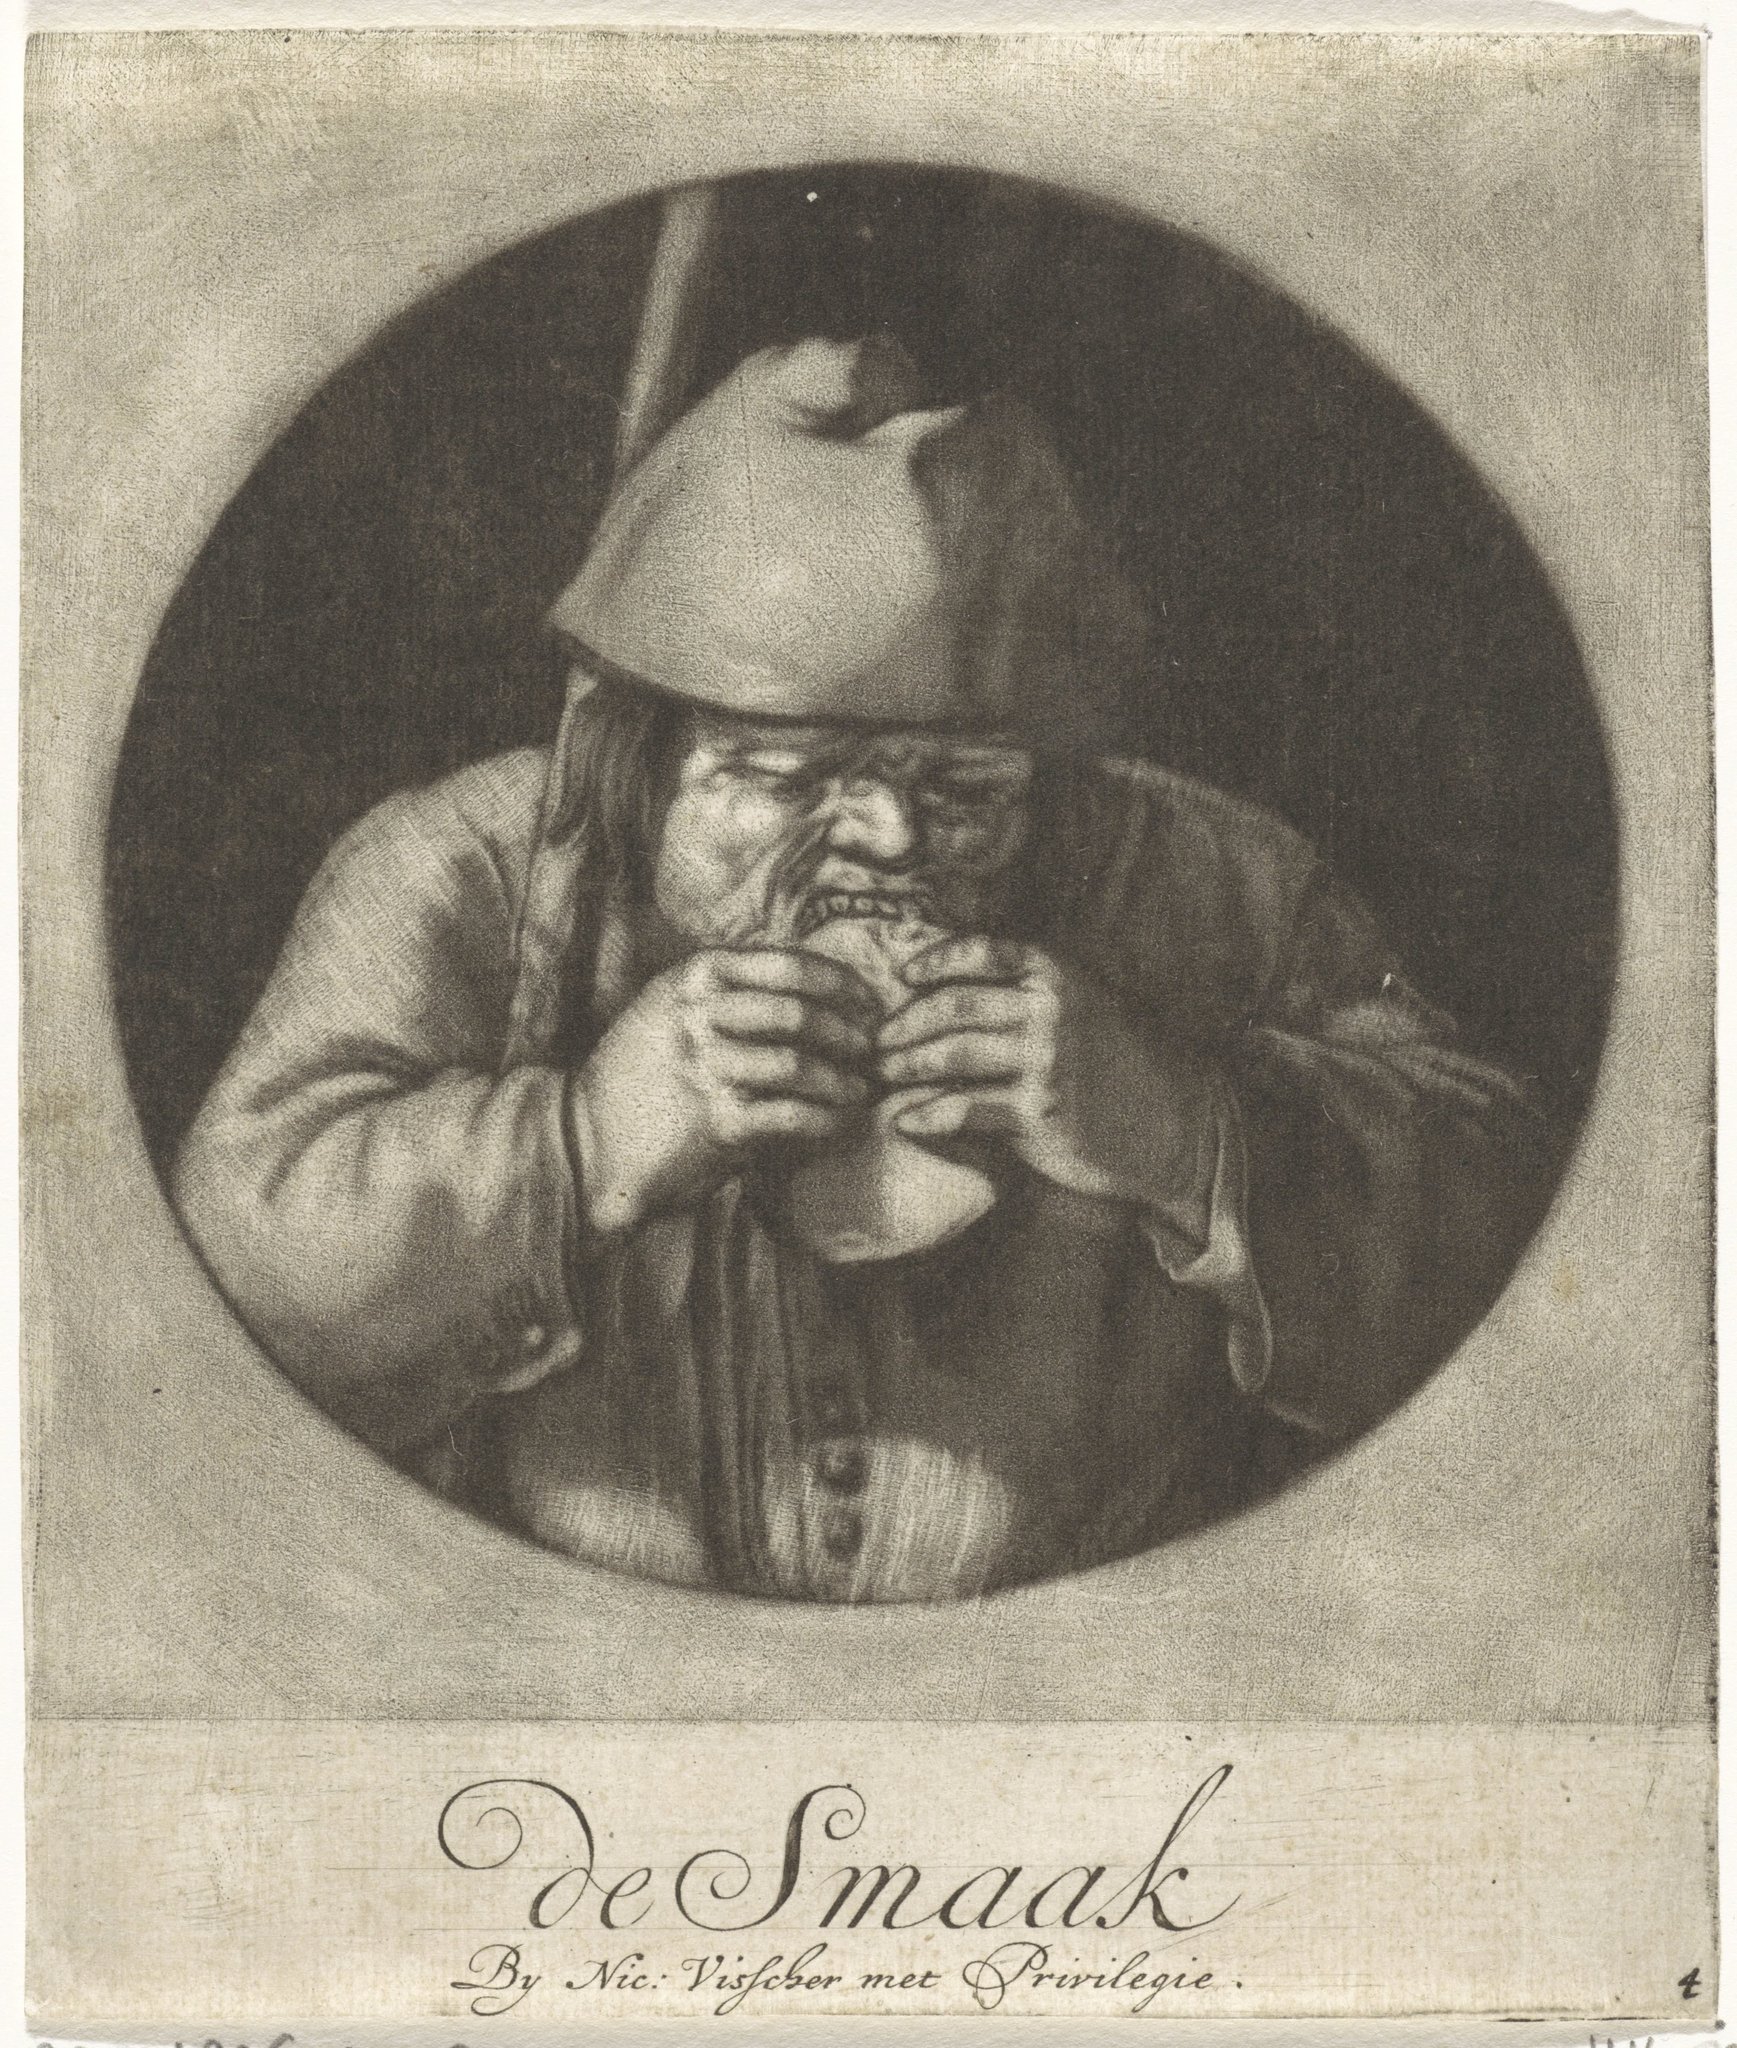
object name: print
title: De Smaak: etende man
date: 1670-1709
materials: paper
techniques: engraving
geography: amsterdam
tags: taste, tasting (one of the five senses), eating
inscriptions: collector's mark: Lugt 2228